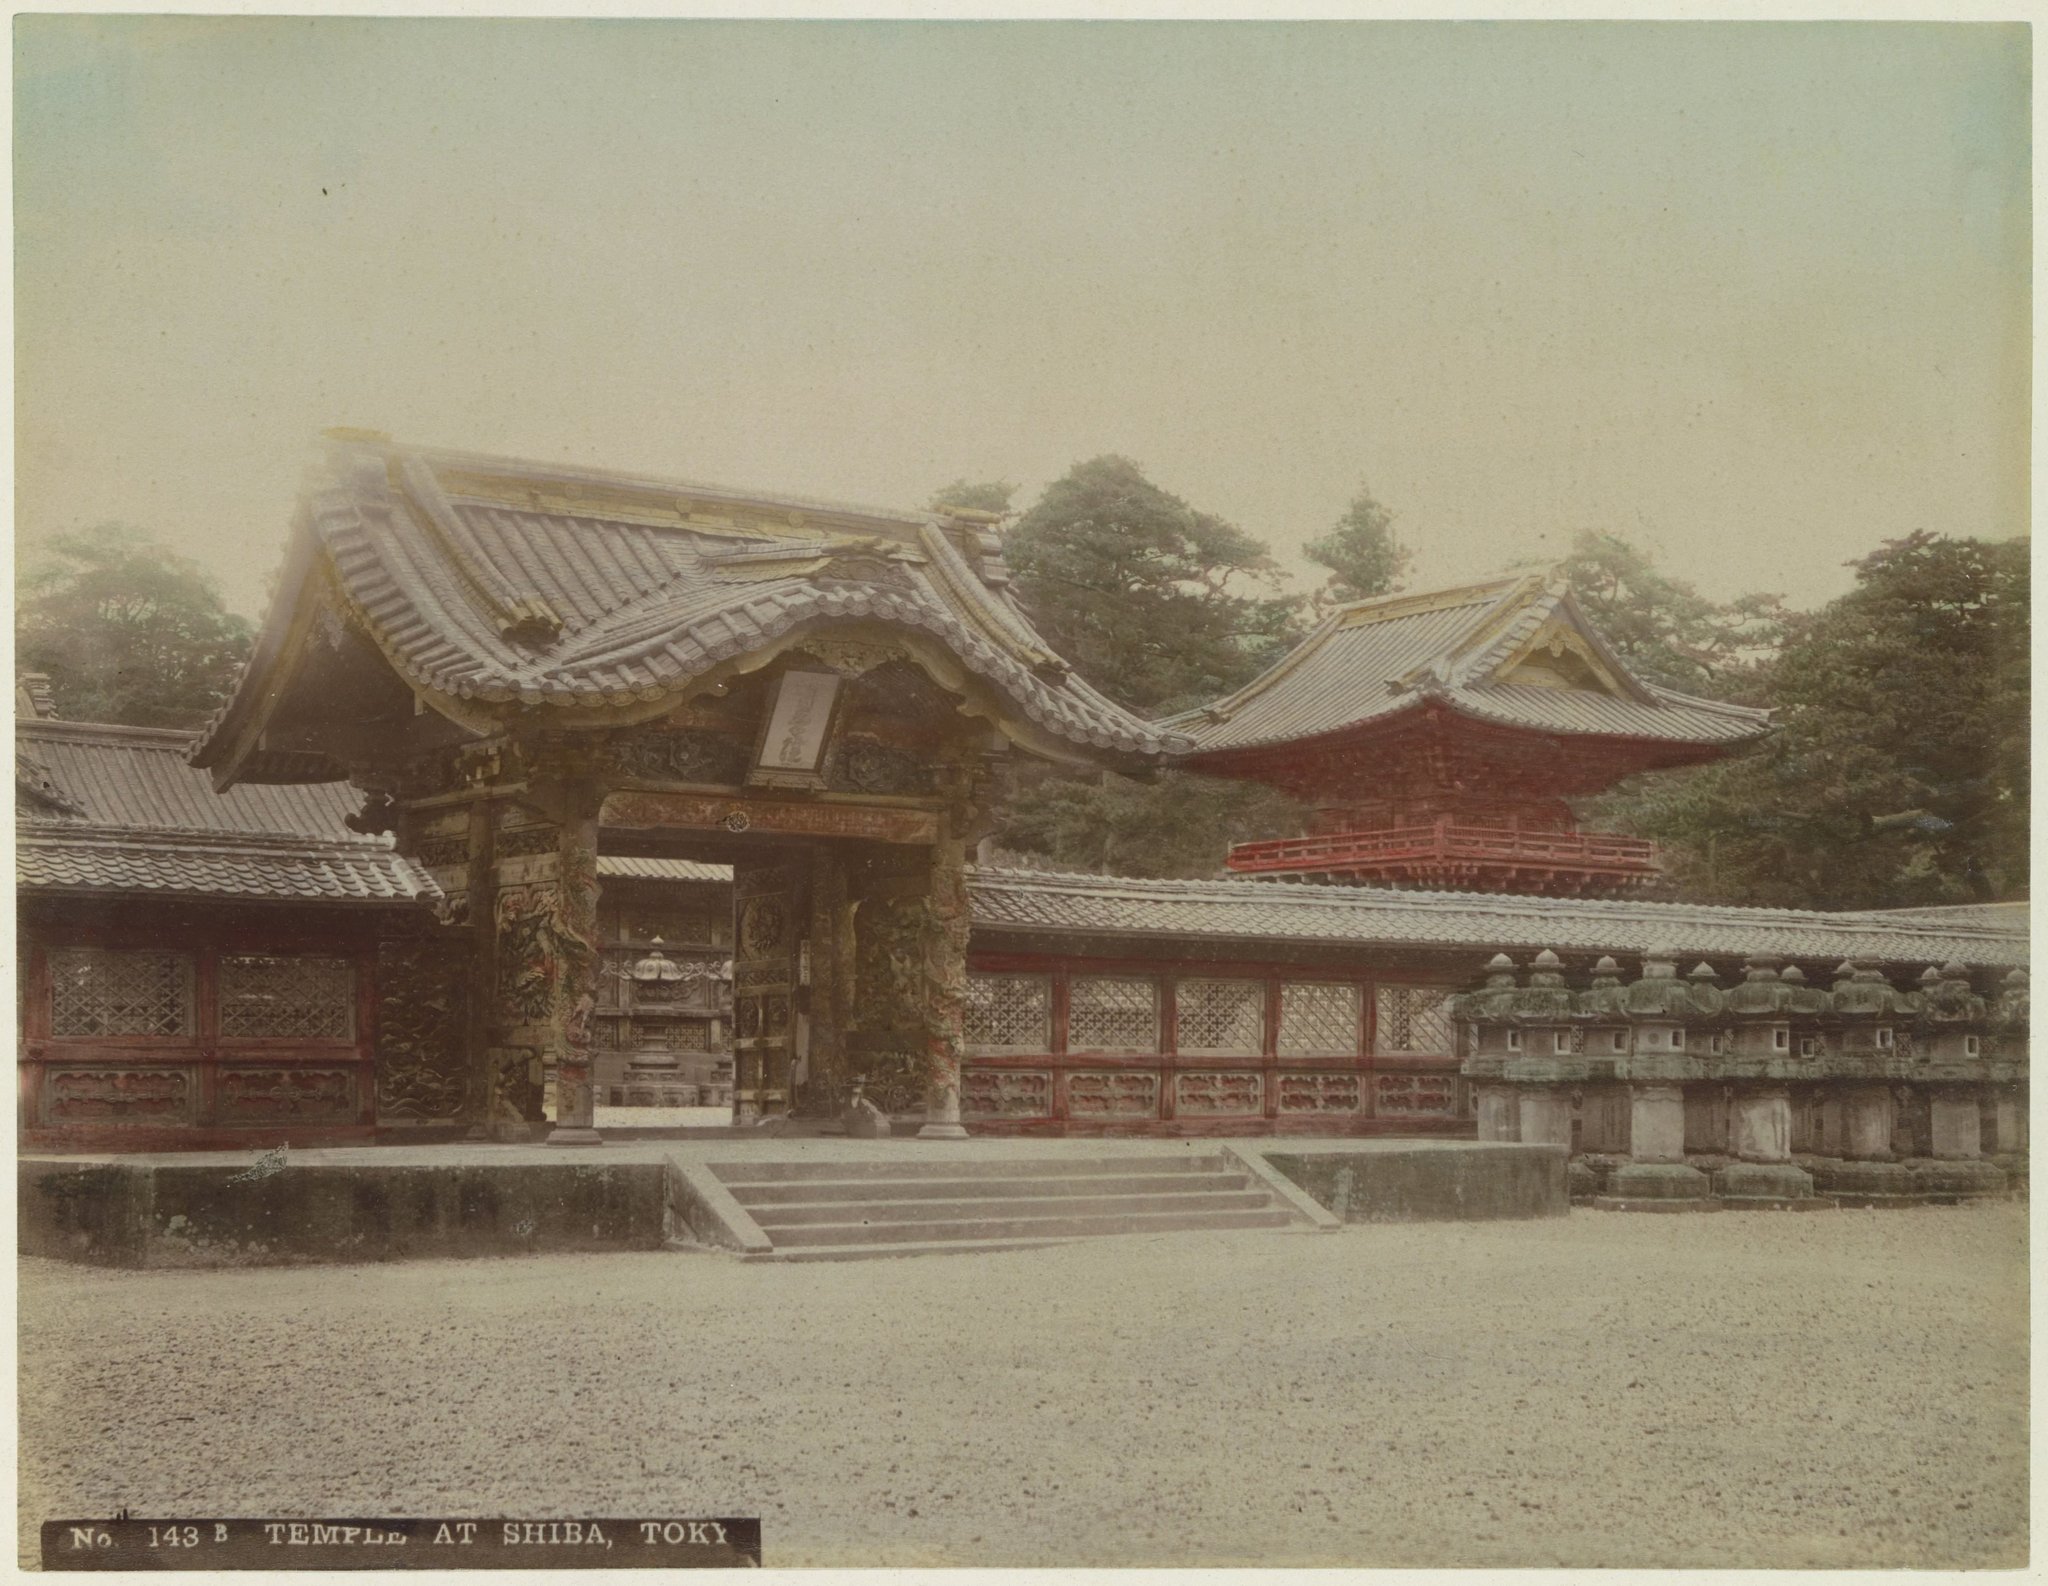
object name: photograph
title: Chokugakumonpoort van de Zojoji-tempel in Tokyo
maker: Anonymous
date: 1870-1900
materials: cardboard, paper, photographic support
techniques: albumen print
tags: temple, shrine ~ hinduism, buddhism, jainism, gate, entrance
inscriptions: negative number: ‘143 B’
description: Onderdeel van Reisalbum met foto's van bezienswaardigheden in Japan.